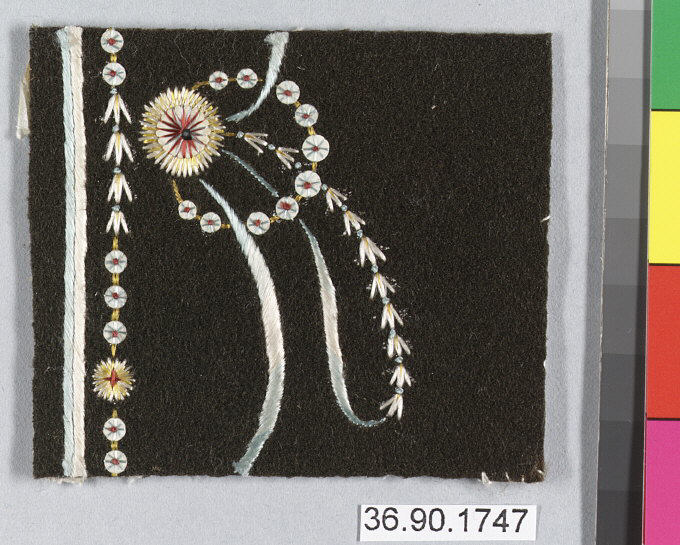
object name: sample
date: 1801-1833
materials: felt, silk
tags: flowers